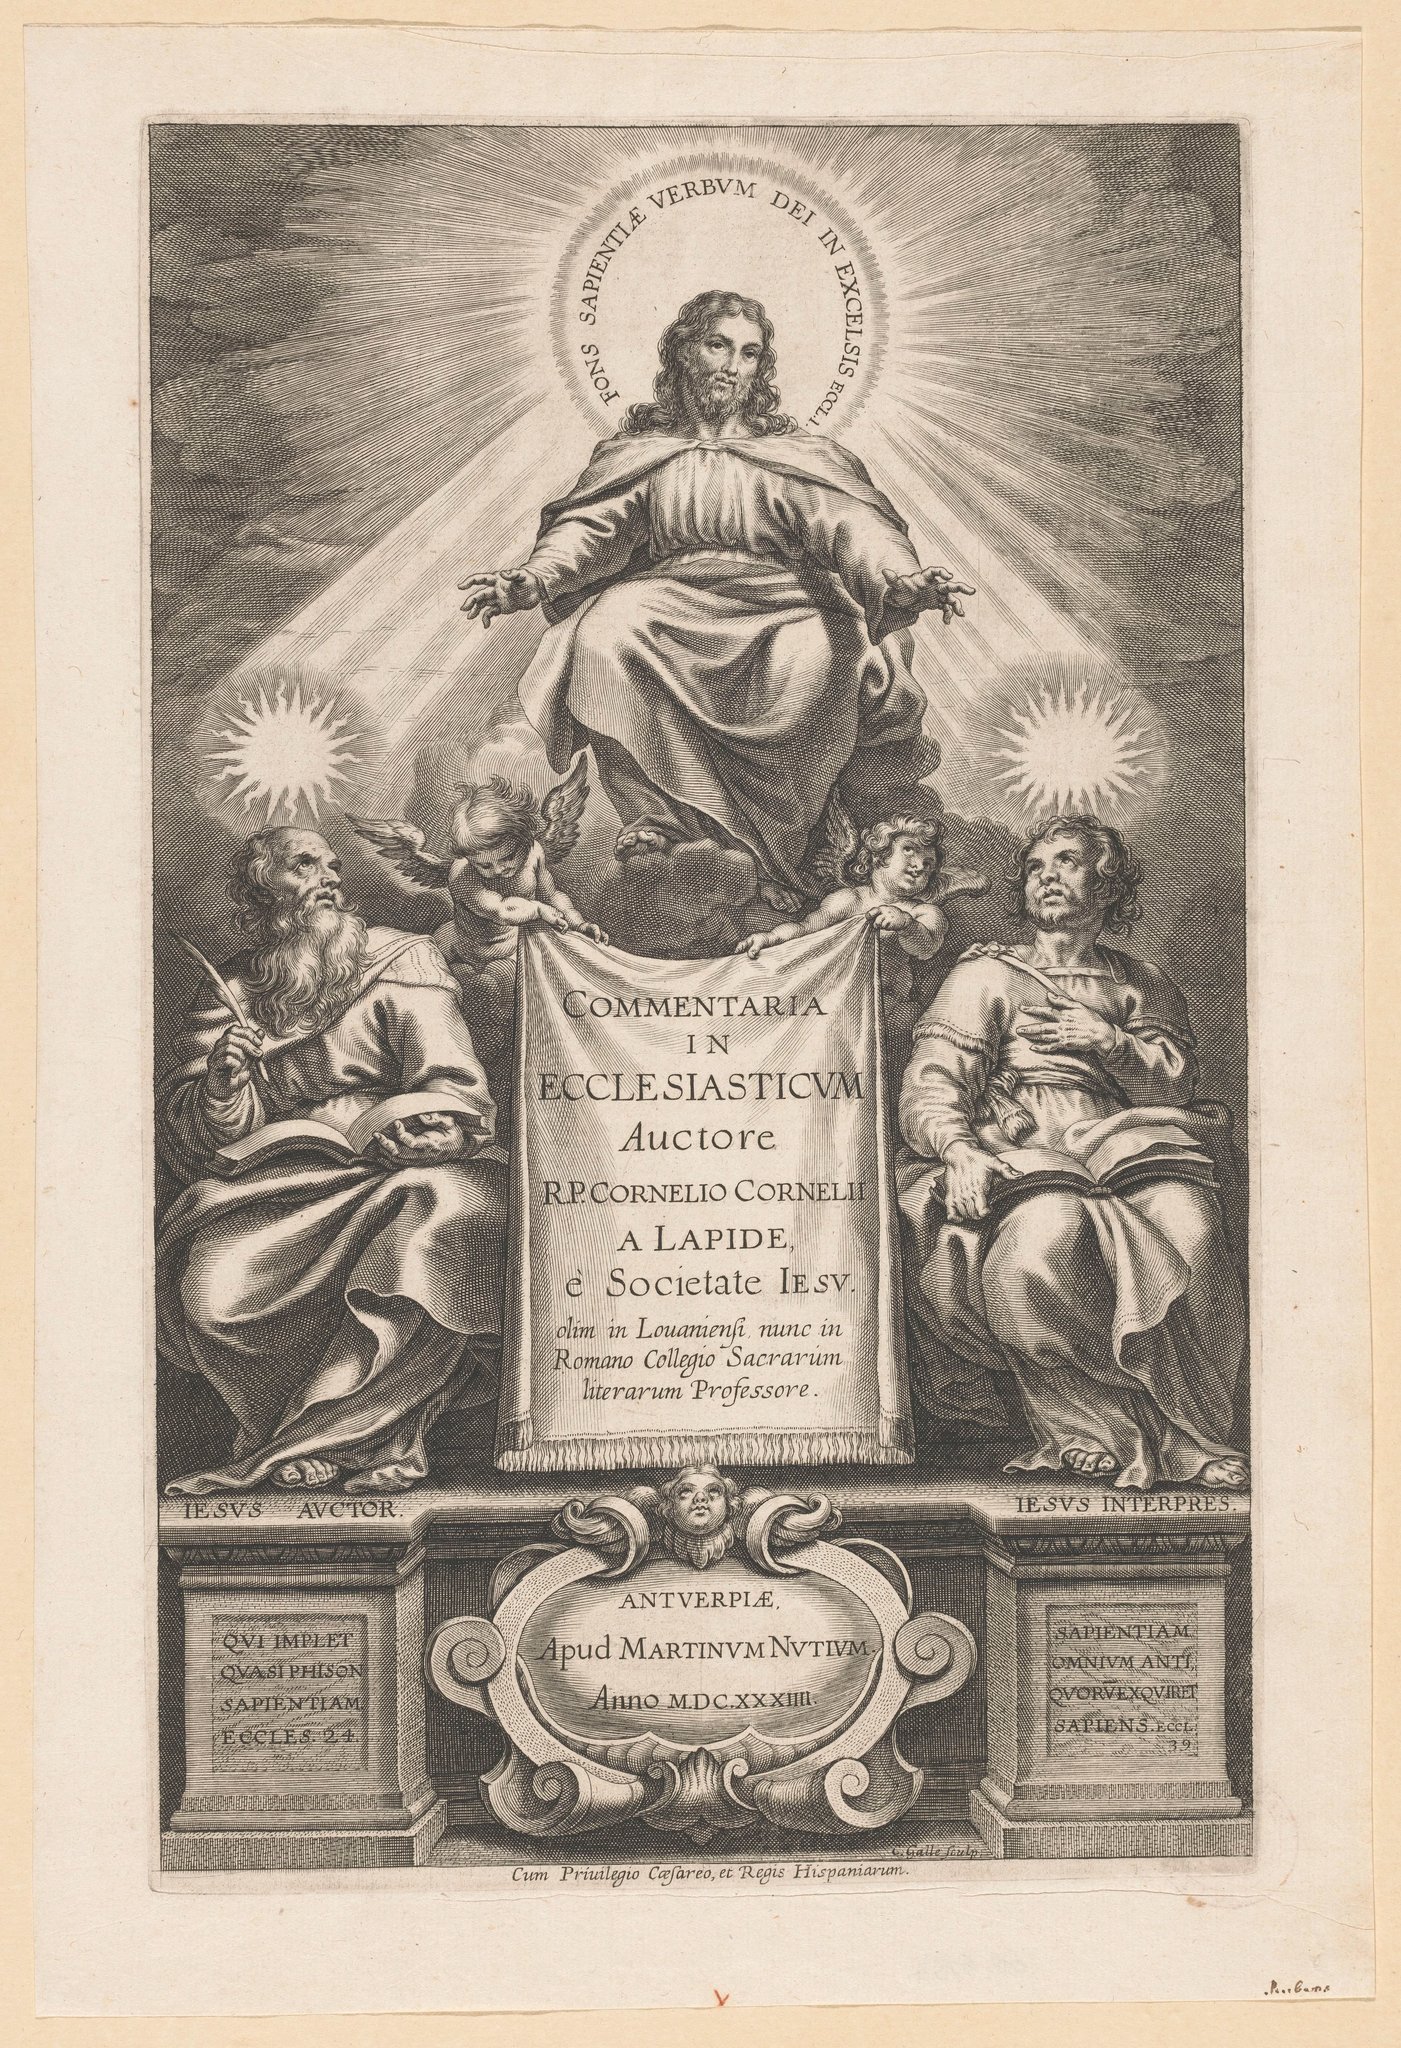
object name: print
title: Titelpagina voor: C. van der Steen, Commentaria in ecclesiasticum, Antwerpen: 1634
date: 1634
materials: paper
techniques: engraving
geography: southern netherlands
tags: the book of ecclesiasticus, the wisdom of jesus sirach, christ enthroned, jesus sirach (not in biblical context)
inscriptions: collector's mark: Lugt 240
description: Christus troont op een wolk. Twee engelen houden een wit doek met de titel van het boek vast. Aan weerszijden van het doek twee zittende figuren. Links de auteur van het bijbelboek Jezus Sirach, een oude man met baard die in een boek schrijft. Rechts een jongere man die in een boek leest, de commentator van het bijbelboek.